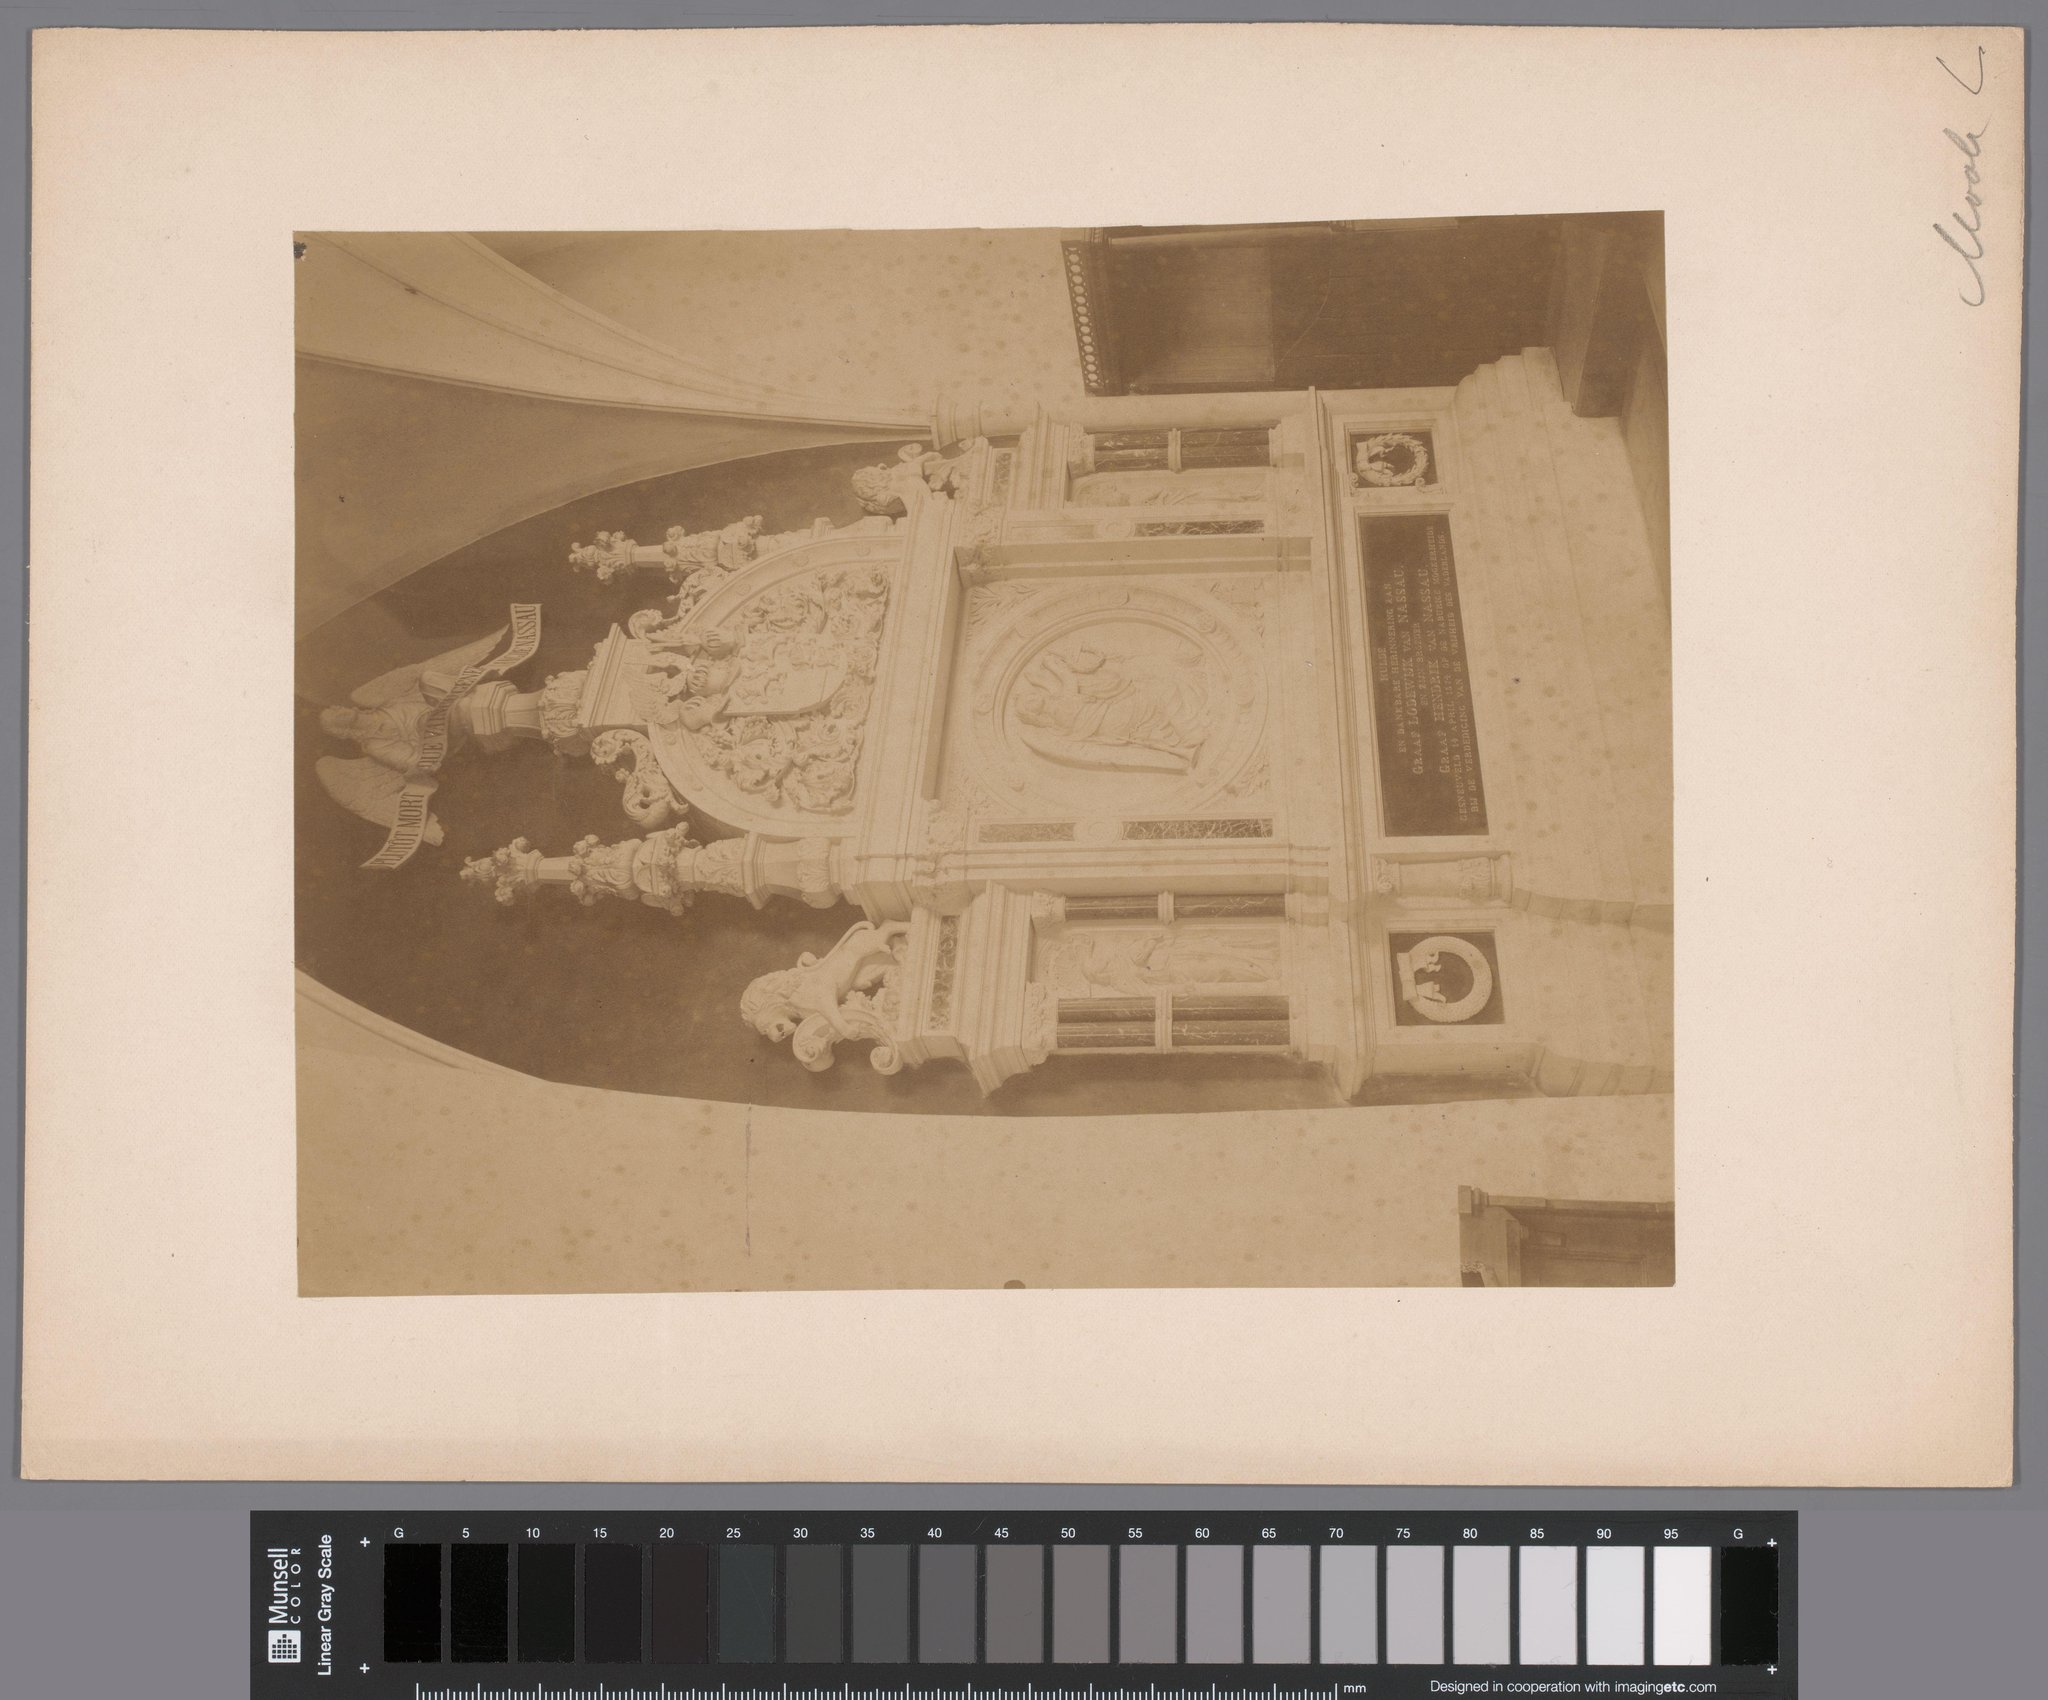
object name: photograph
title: Cenotaaf van Lodewijk en Hendrik van Nassau in de Sint-Joriskerk te Heumen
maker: anoniem (monumentenzorg)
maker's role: fotograaf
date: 1900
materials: cardboard, photographic support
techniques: albumen print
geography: heumen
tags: sham-grave, cenotaph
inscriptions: annotation: ‘Mook L’, annotation: ‘Monument ter gedachtenis der graven Lodwijk en Hendrik van Nassau/ gesneuveld 14 april 1574 op den Mookerheide/ Monument ontworpen door F.L. Straké Haarlem/ 1890/ geph. Mei 1900’